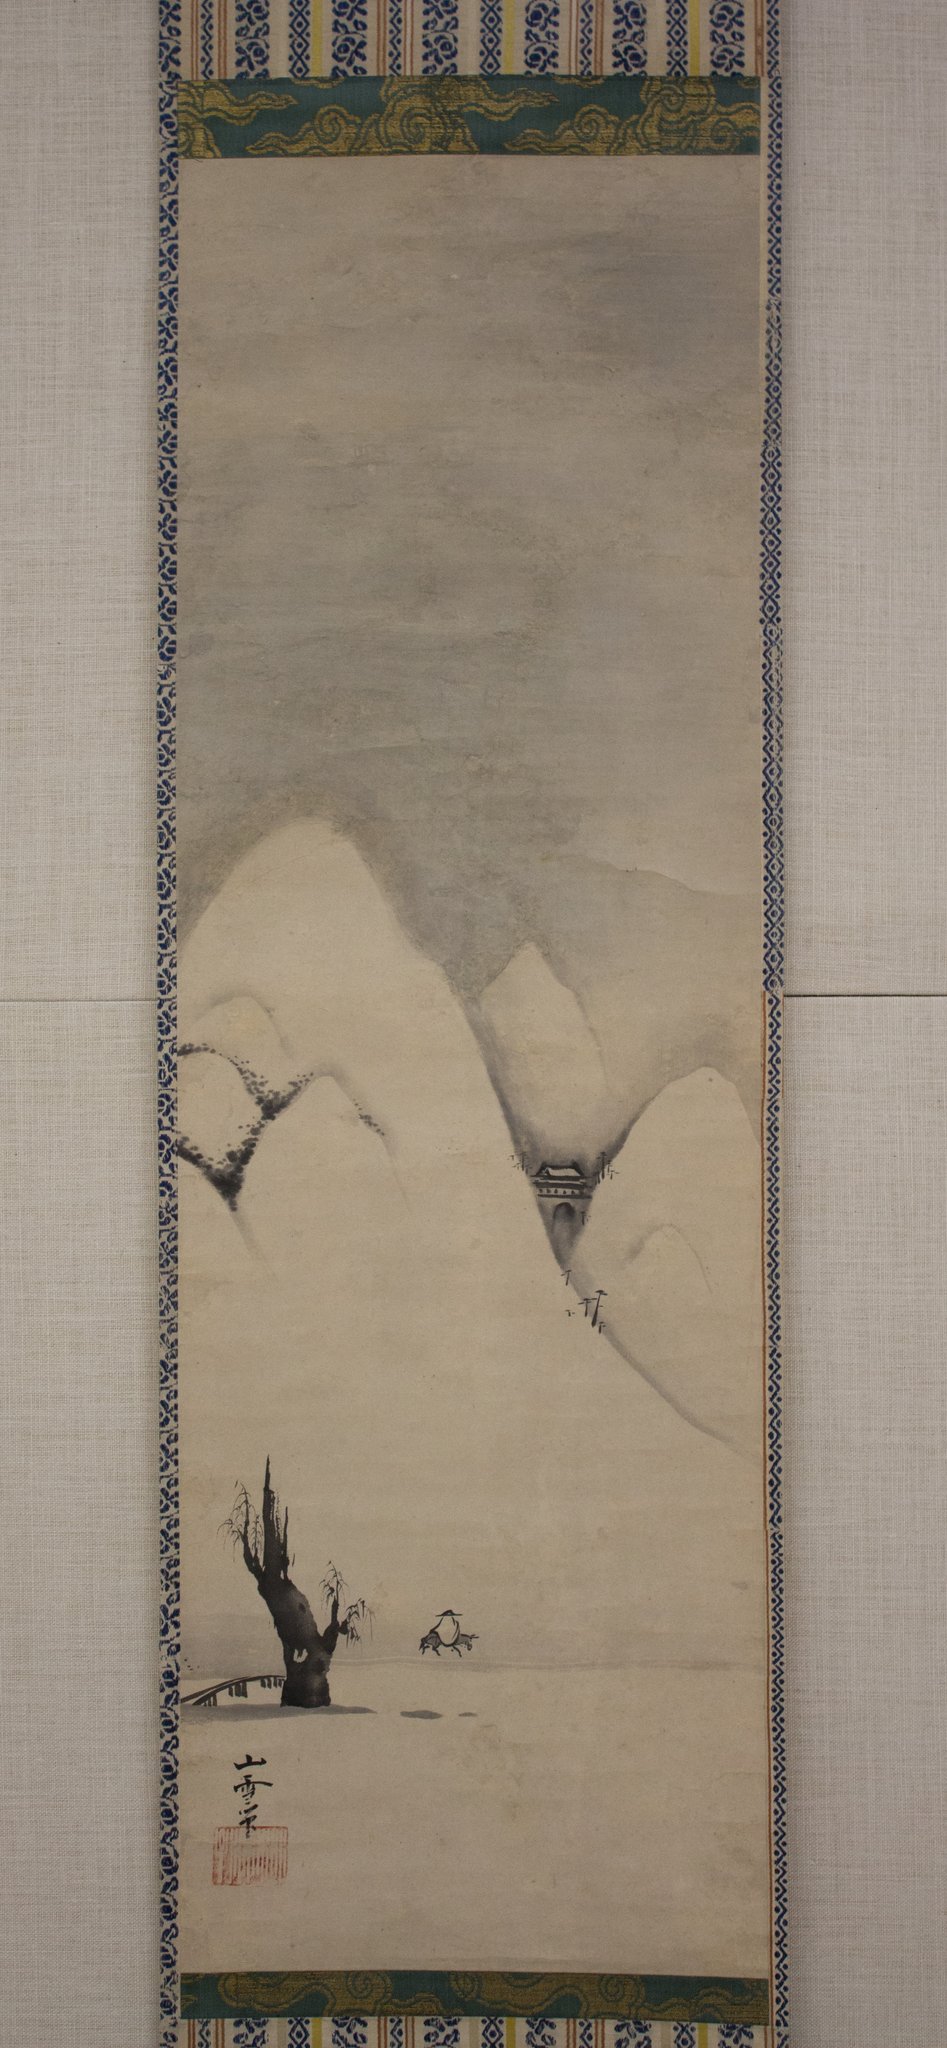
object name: hanging scroll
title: Winter Landscape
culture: japanese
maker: kano sansetsu 狩野山雪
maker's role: artist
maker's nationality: japanese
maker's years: 1590-1651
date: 1626-1650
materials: ink, paper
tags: mountains,landscapes,winter,snow